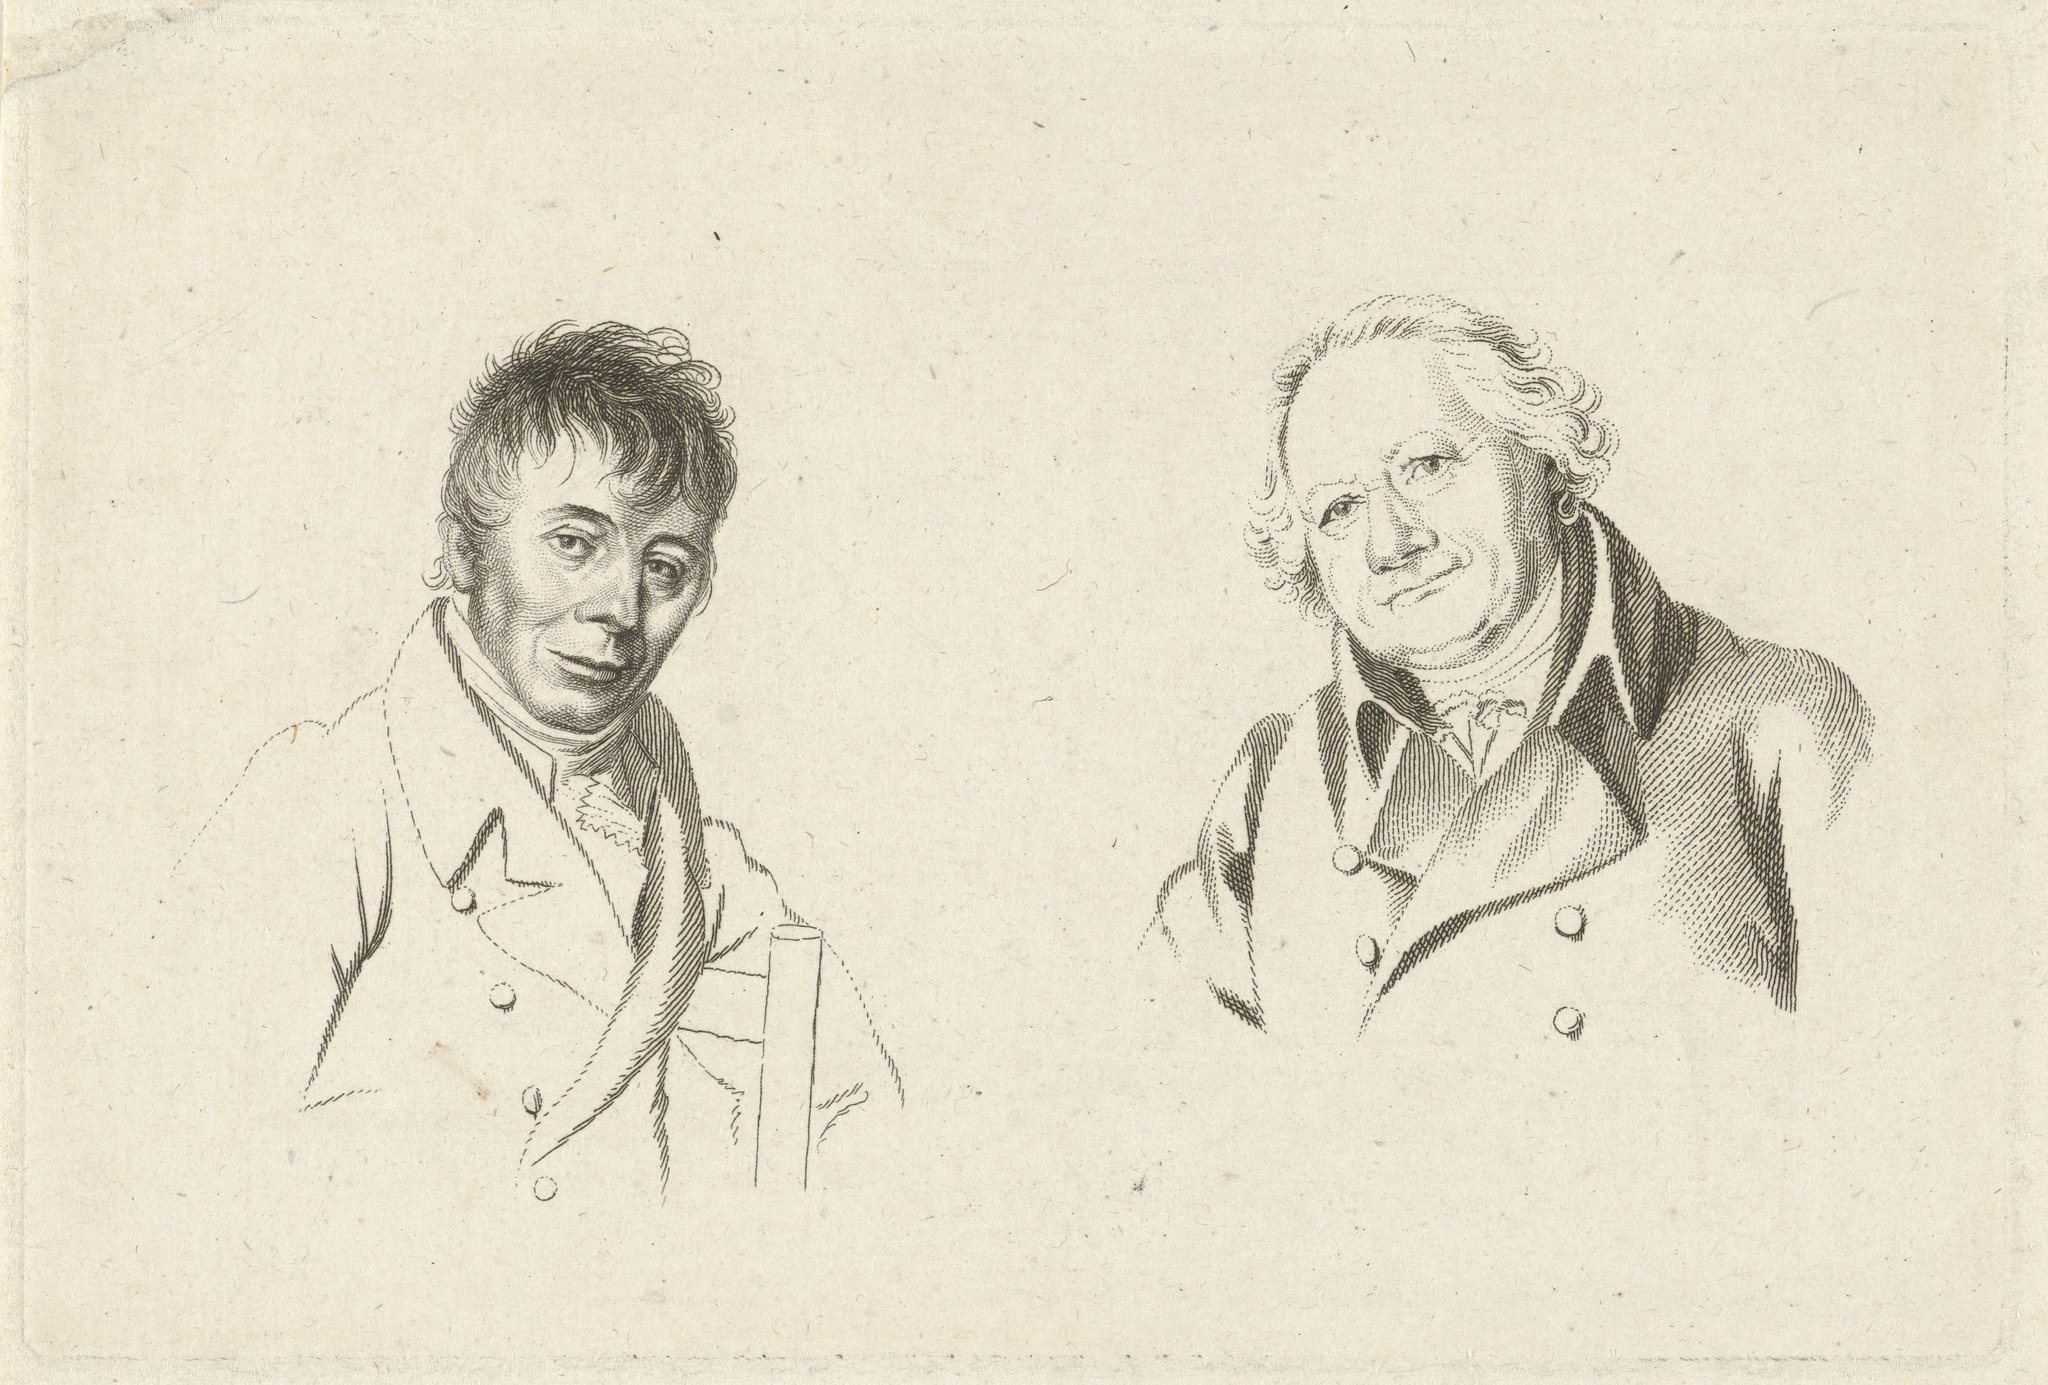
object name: print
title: Portretten van Daniël Dupré en Christiaan Welmeer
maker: jacob ernst marcus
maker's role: draughtsman, print maker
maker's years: 1774-1826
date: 1813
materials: paper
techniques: etching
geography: amsterdam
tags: daniël dupré, christiaan welmeer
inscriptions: collector's mark: Lugt 2228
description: Latere staat van de prent gebruikt in: Jacob Ernst Marcus, Etudes gravées. Amsterdam: S. de Grebber, 1826.